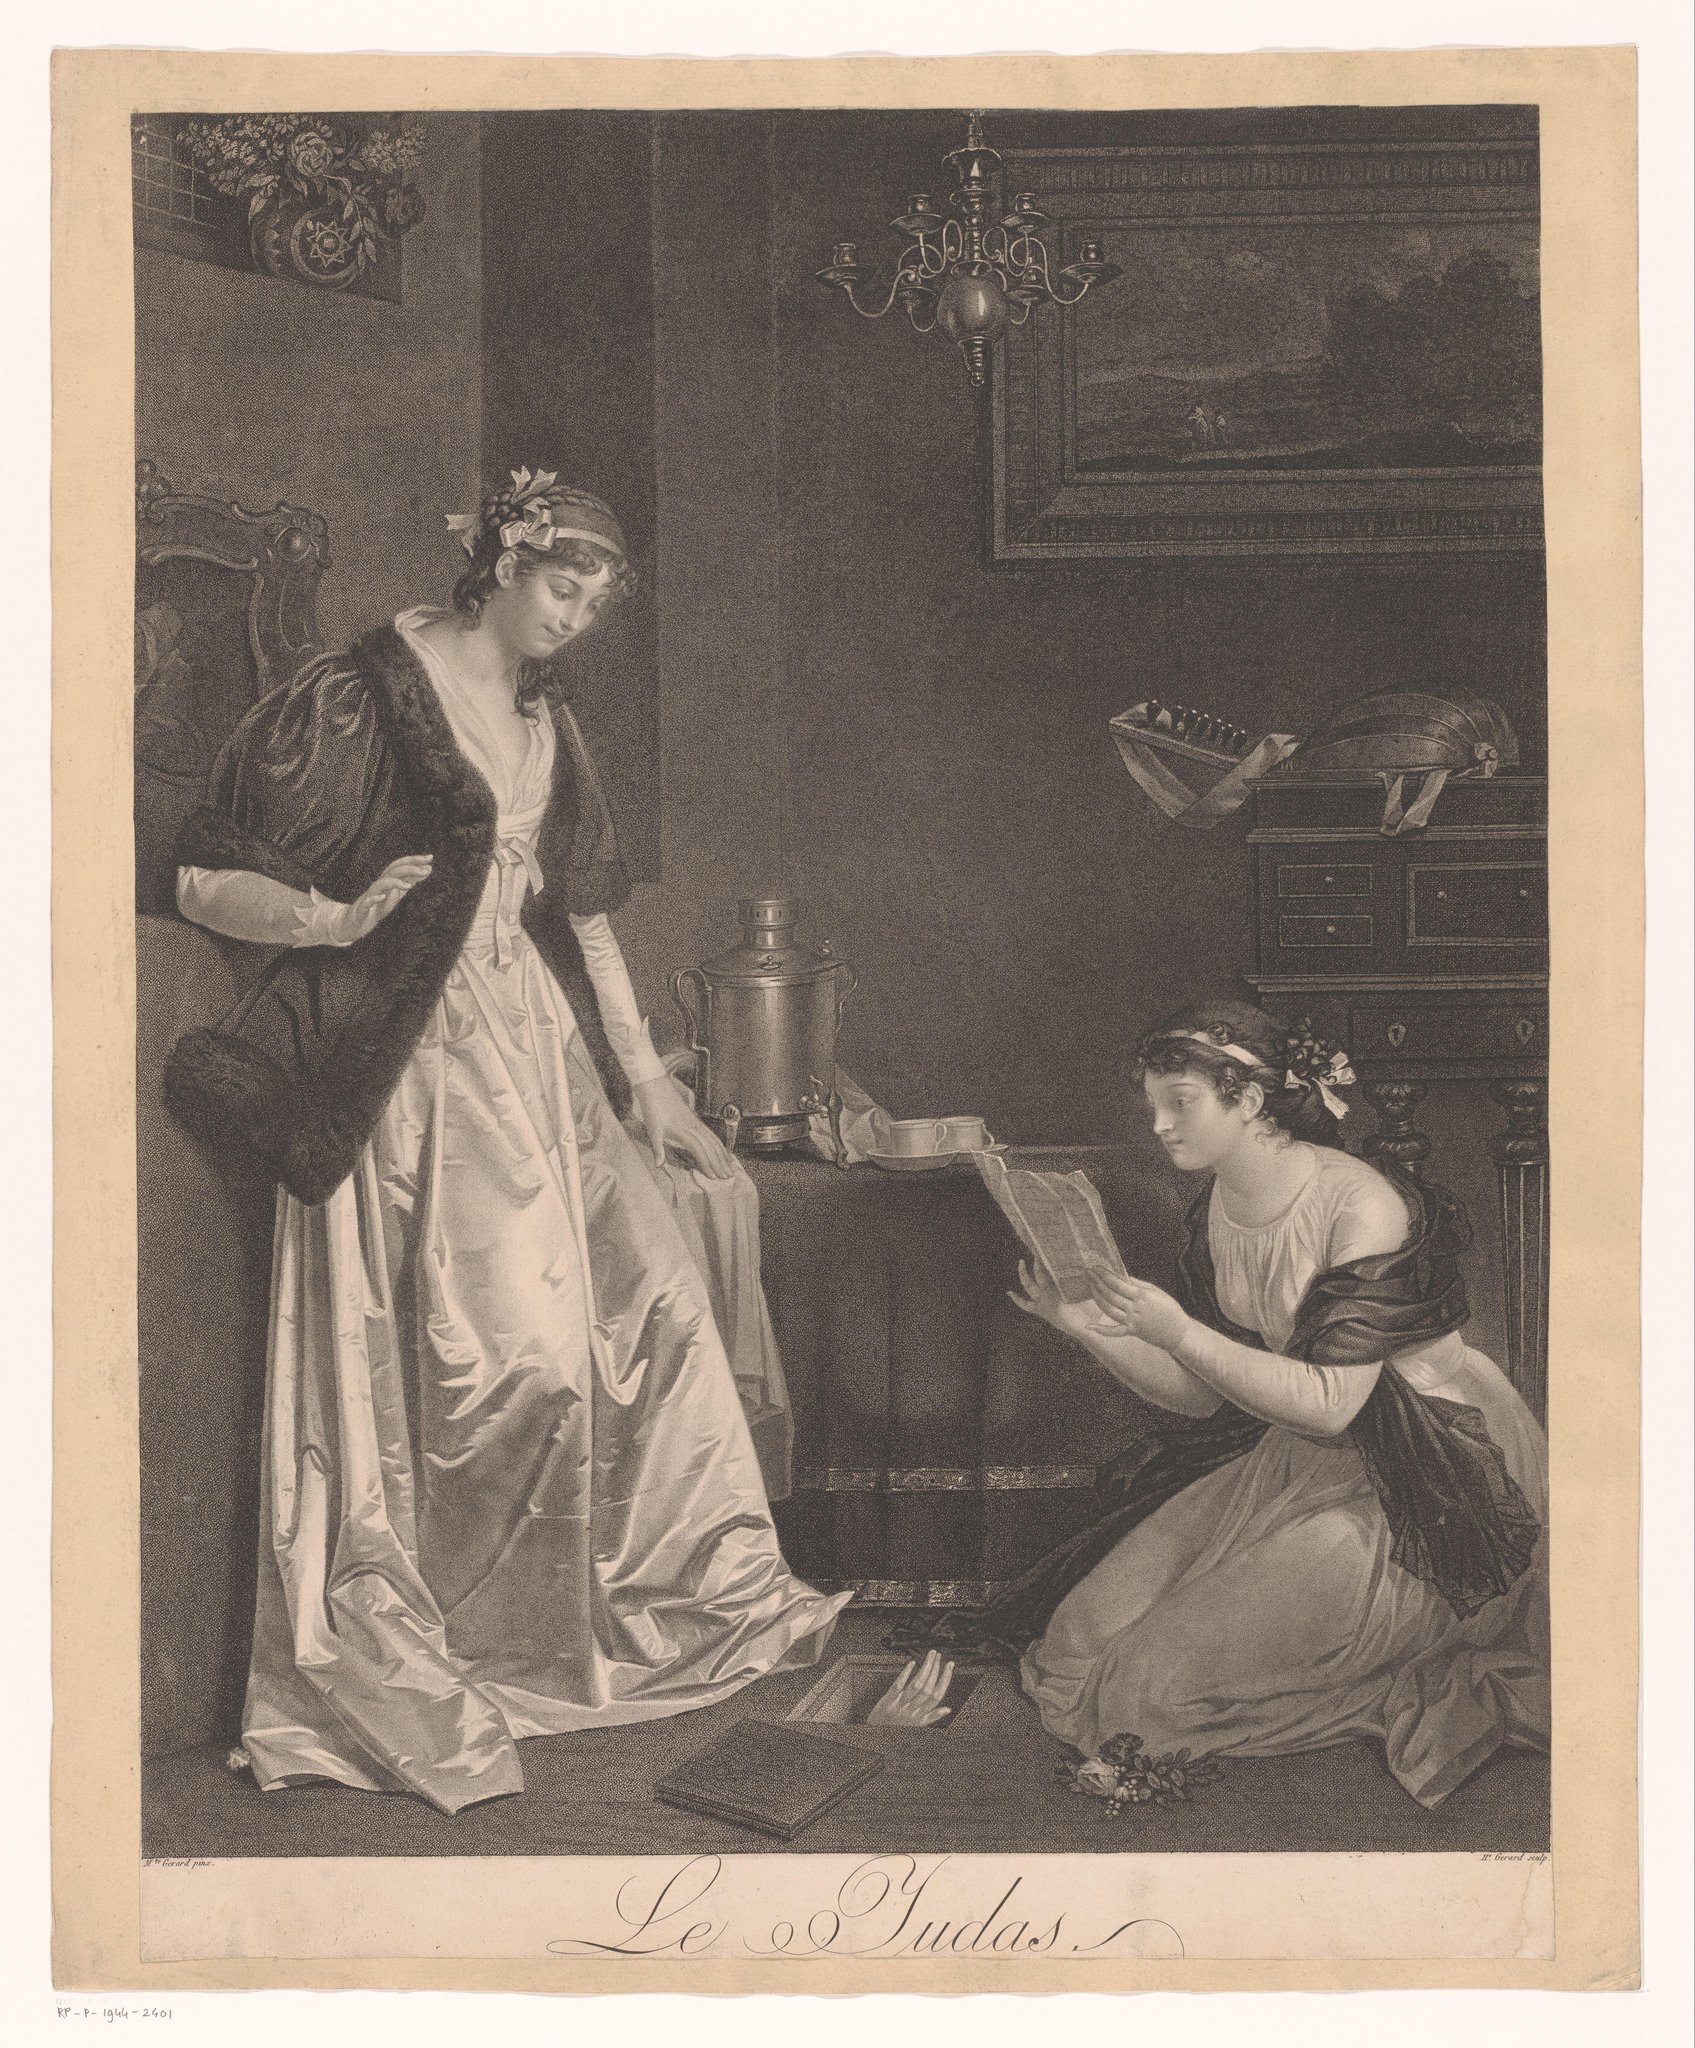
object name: print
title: Interieur met twee jonge vrouwen die een brief geleverd krijgen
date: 1789-1806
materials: paper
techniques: etching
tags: delivering; receiving (~ postal matter), letter, envelope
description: Le Judas verwijst naar het geheime luik op de grond, waar een hand uitsteekt.